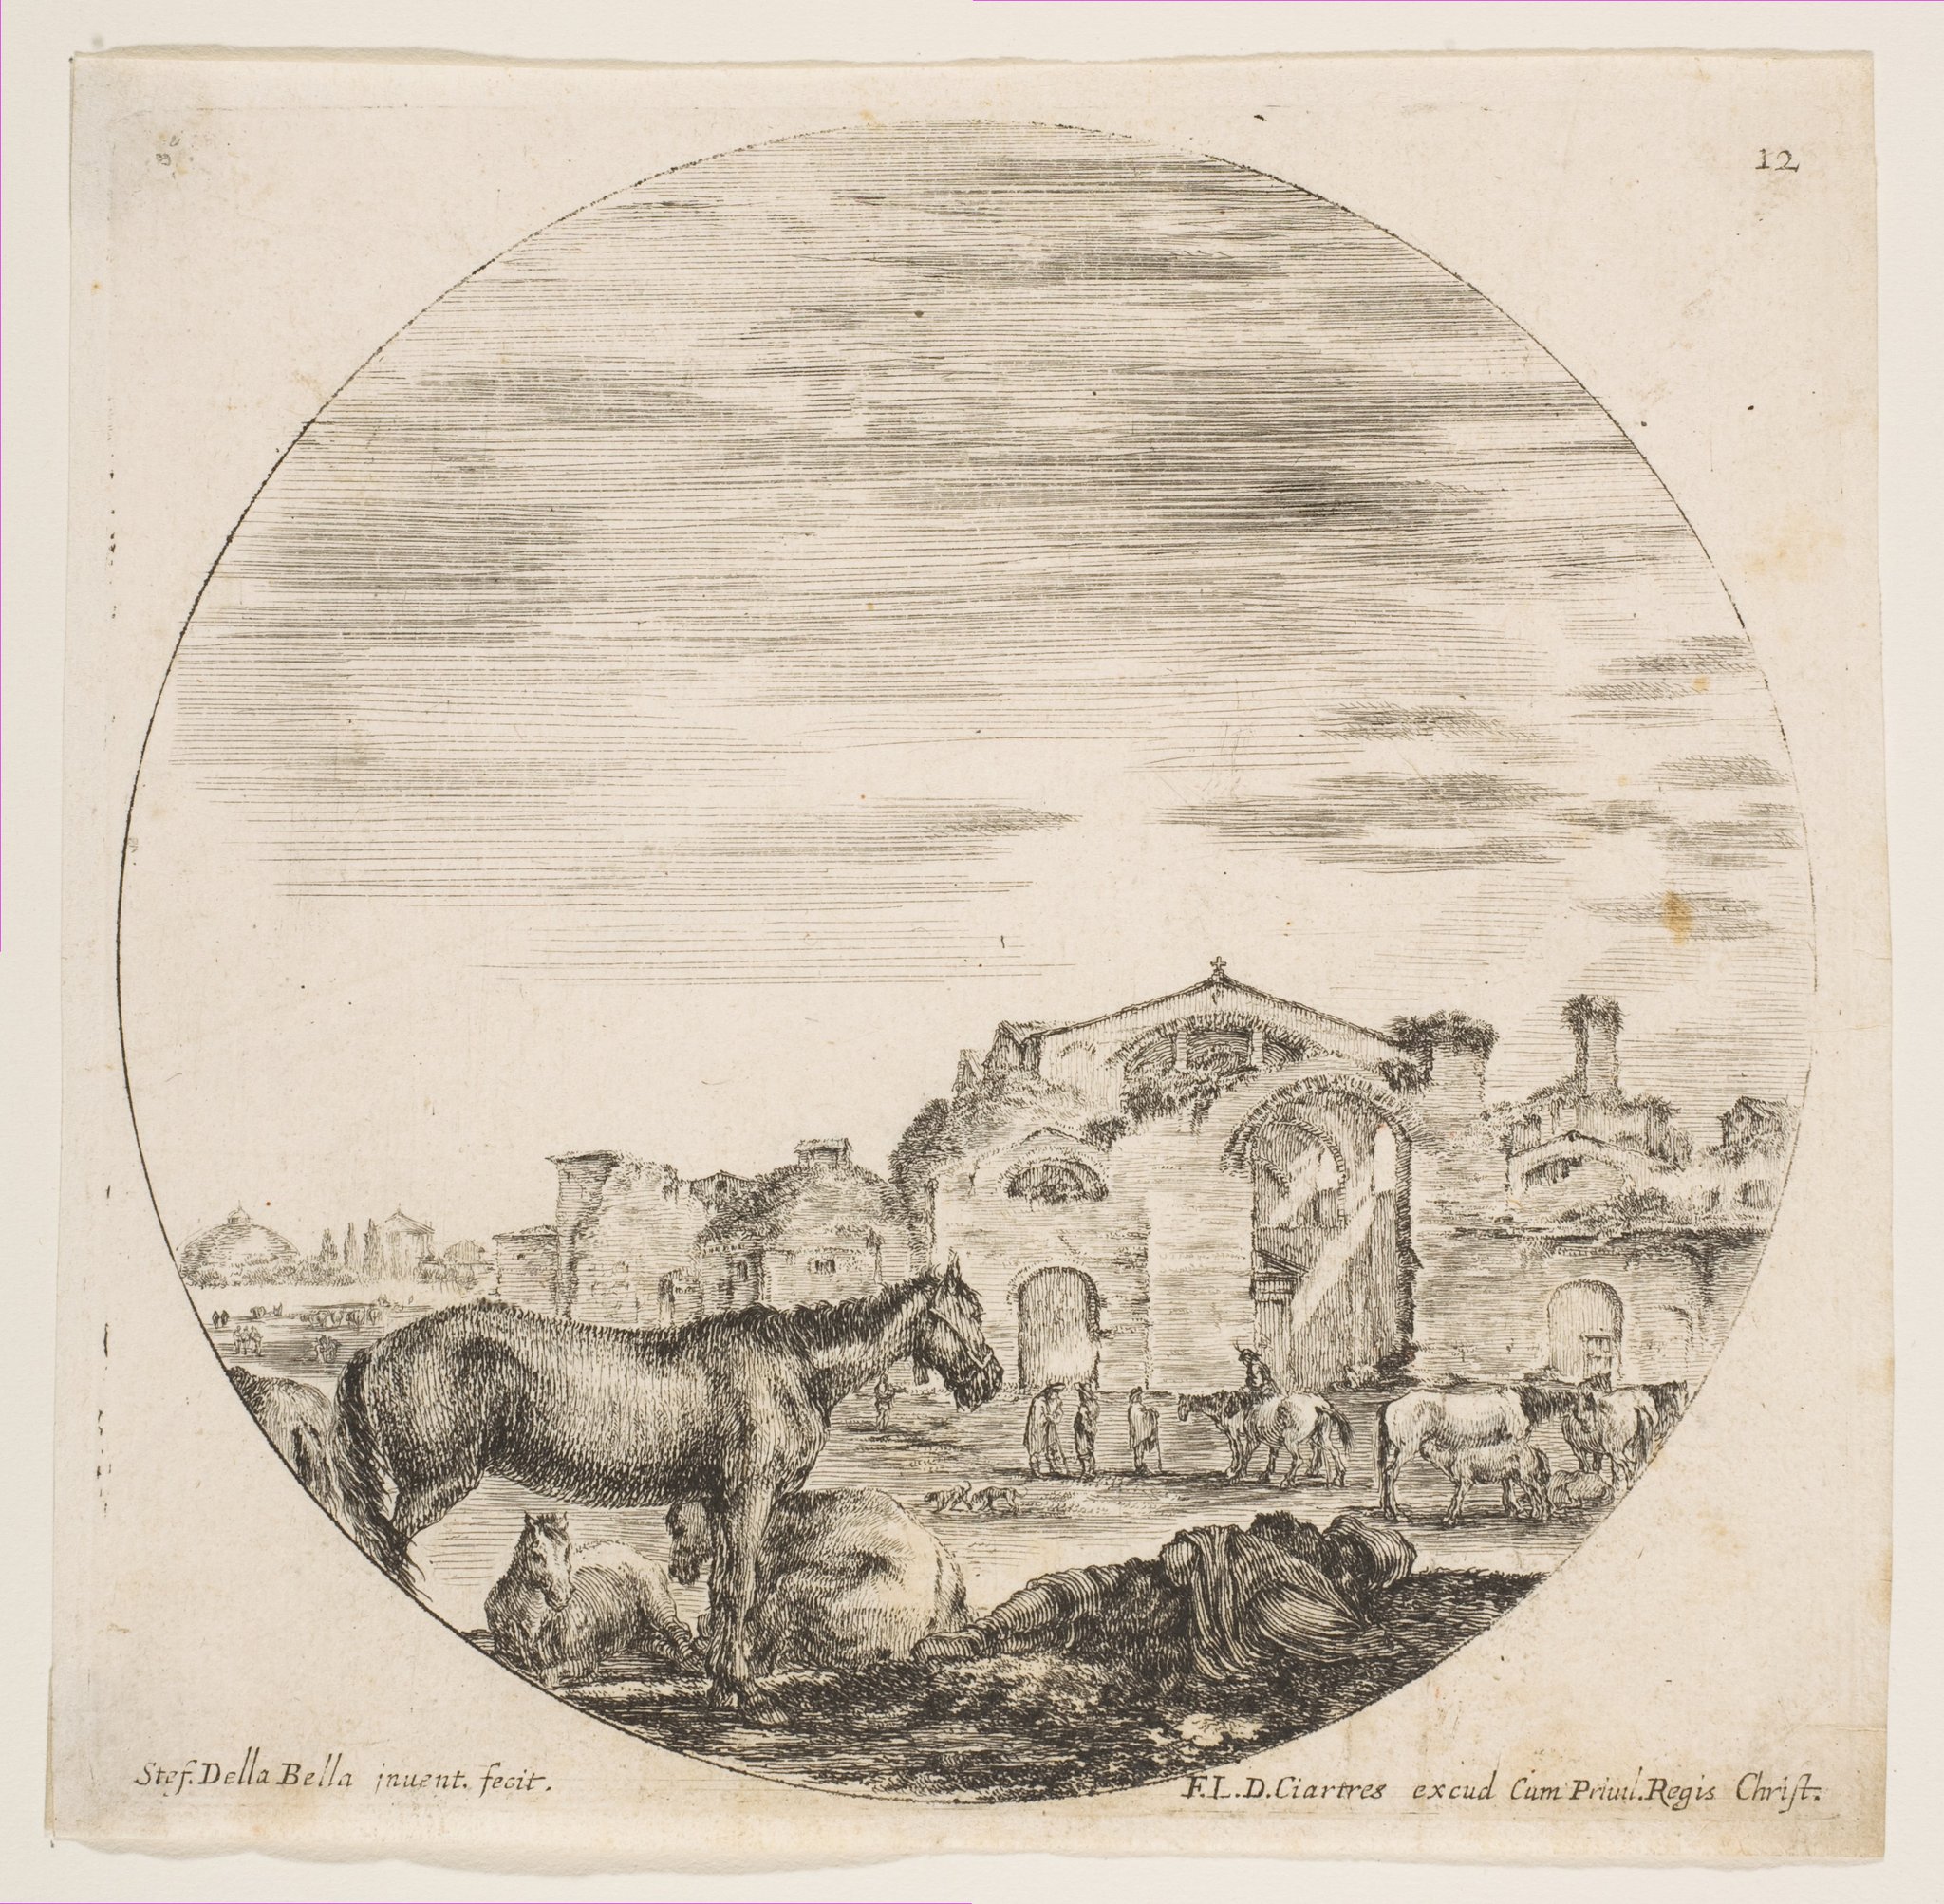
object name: print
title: A shepherd sleeping on the ground at right, three horses at left, other horses and various figures to right, the Baths of Diocletian in the background, plate 12 from "Roman landscapes and ruins" (Paysages et ruines de Rome)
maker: stefano della bella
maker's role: artist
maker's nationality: italian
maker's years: 1610-1664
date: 1646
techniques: etching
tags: ruins,men,horses,shepherds,rome